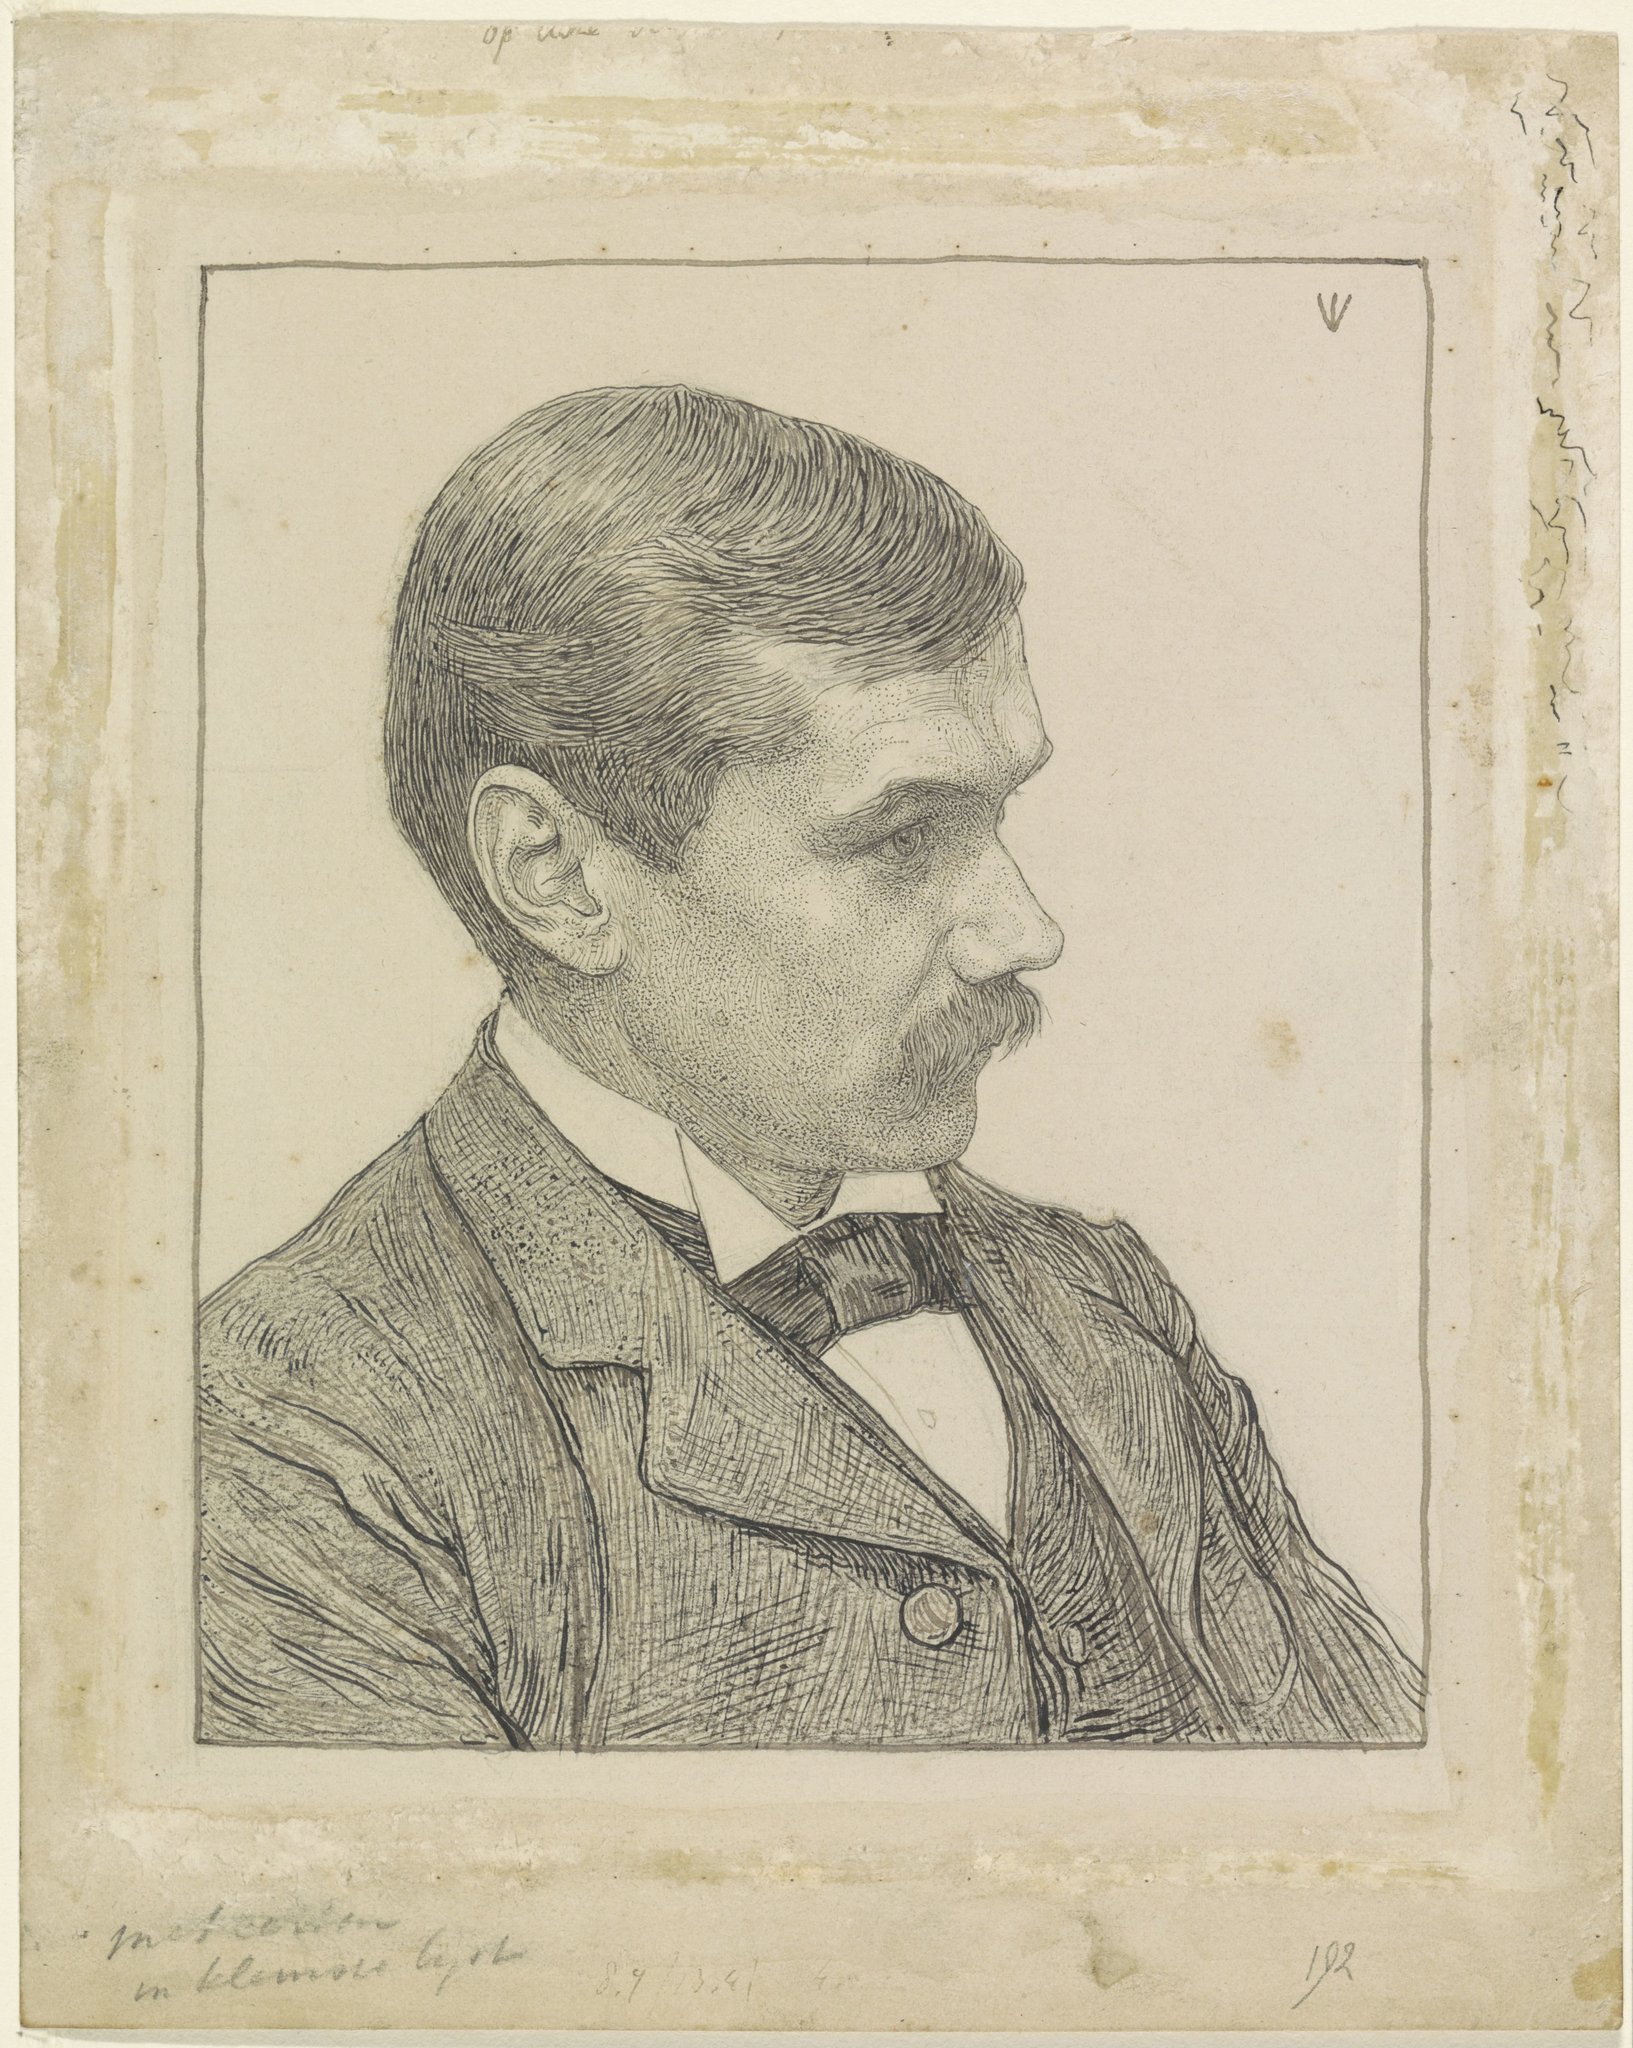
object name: drawing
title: Portret van de schrijver Frederik Willem van Eeden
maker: jan veth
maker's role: designer, draughtsman, painter, print maker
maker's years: 1864-1925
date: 1874-1925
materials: ink, paper, pencil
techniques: brush, pen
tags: frederik van eeden, historical persons, portrait of a writer, portrait, self-portrait of artist